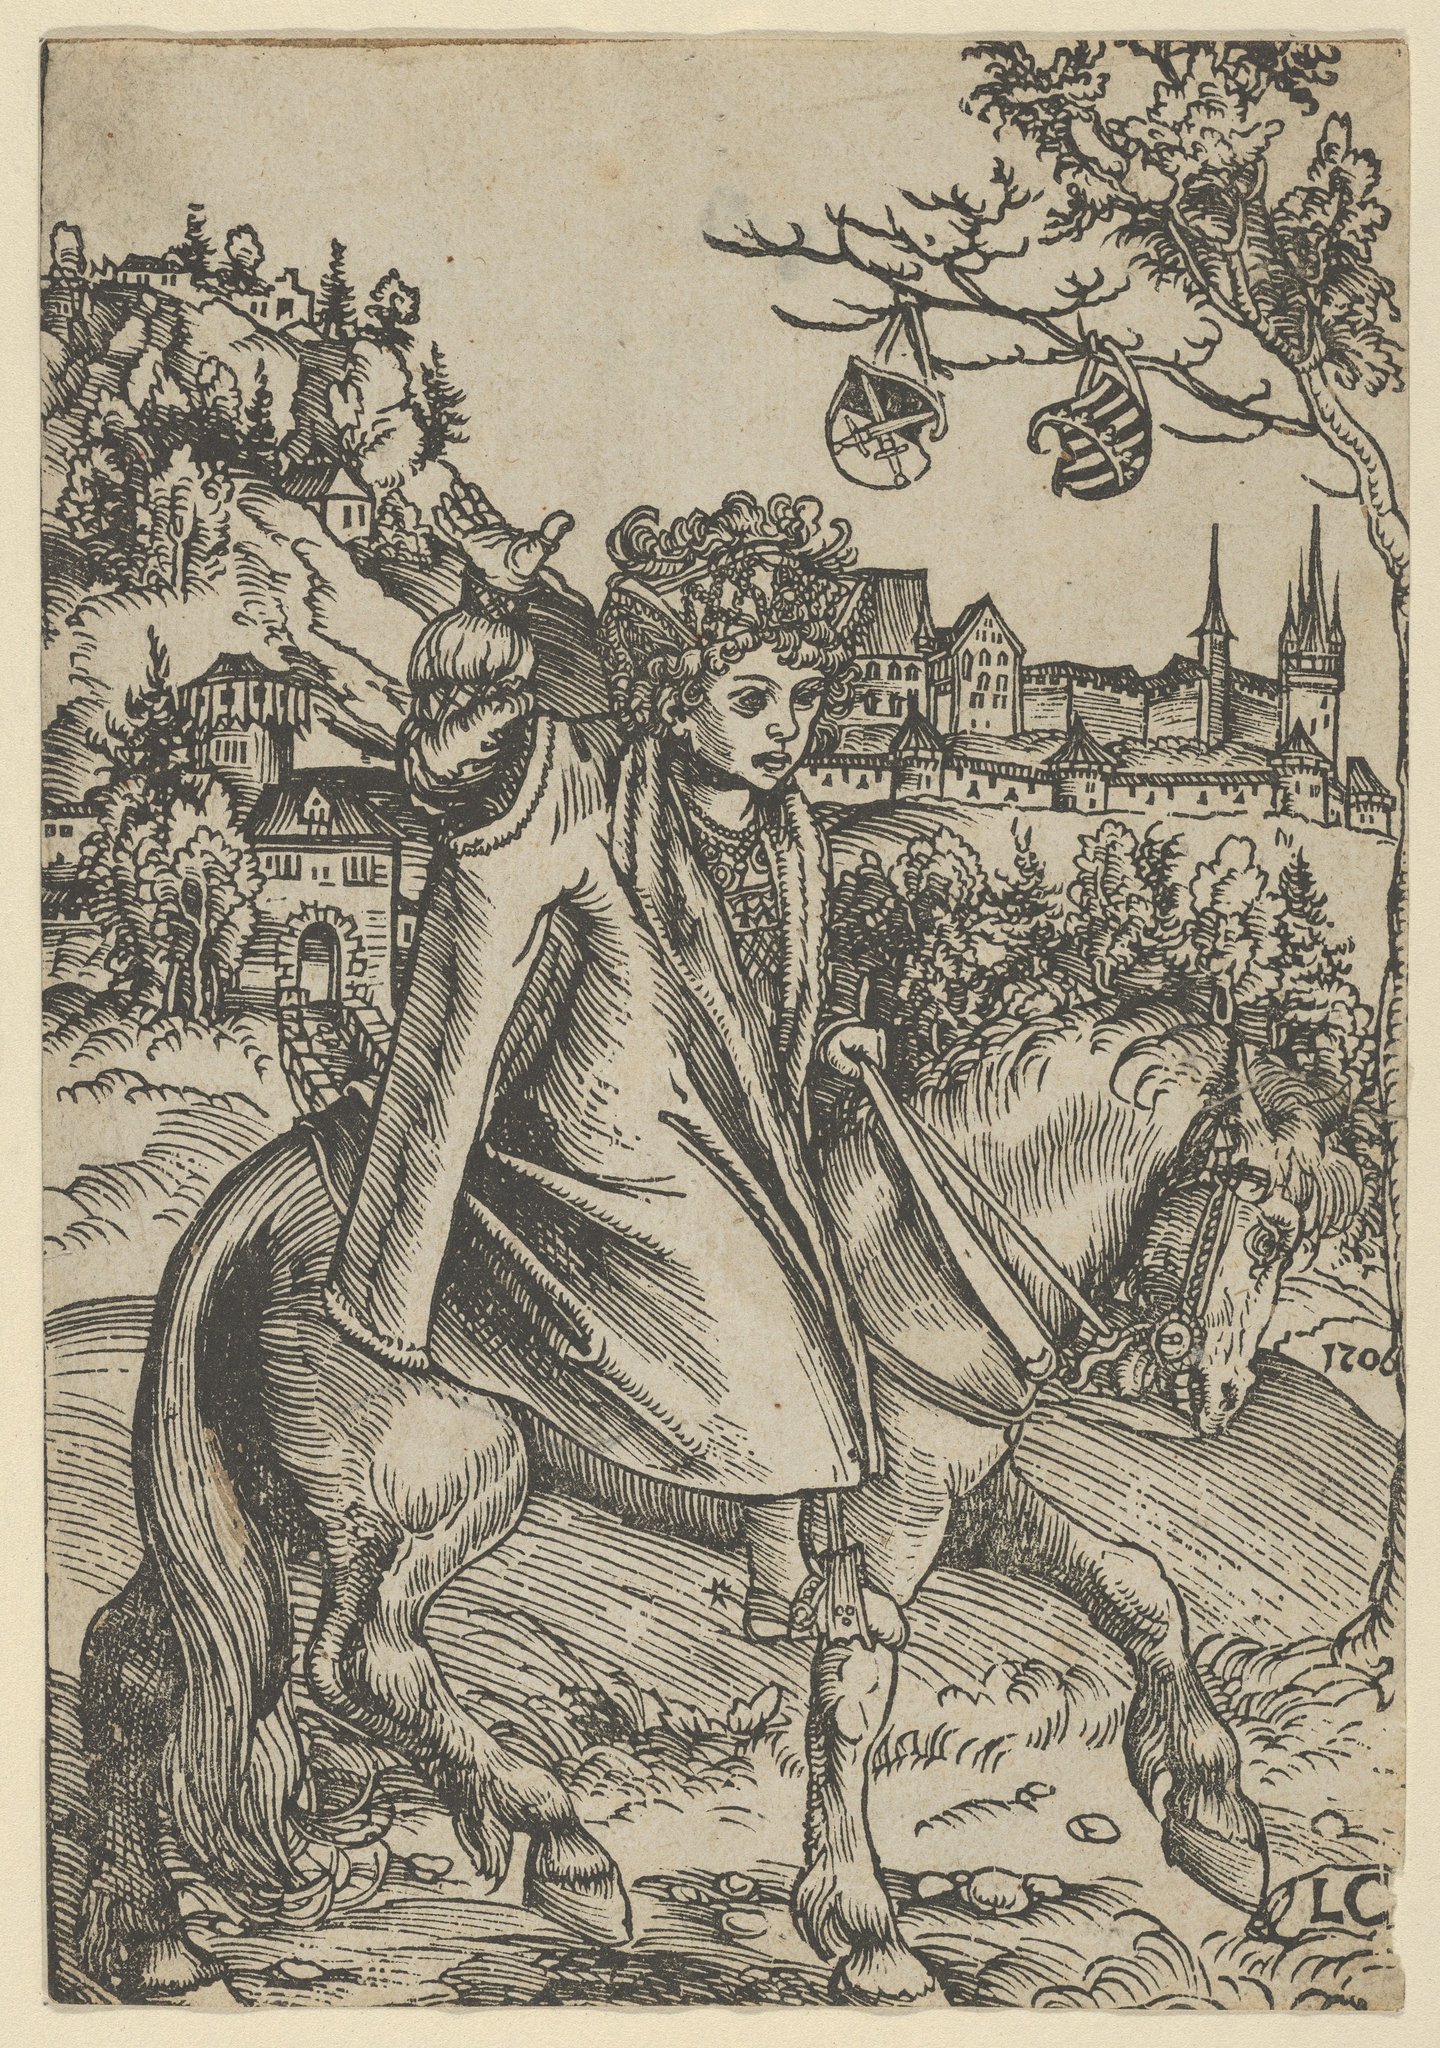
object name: print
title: A Saxon Prince on Horseback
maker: lucas cranach the elder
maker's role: artist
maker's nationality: german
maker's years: 1472-1553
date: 1472-1553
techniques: woodcut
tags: princes,horses